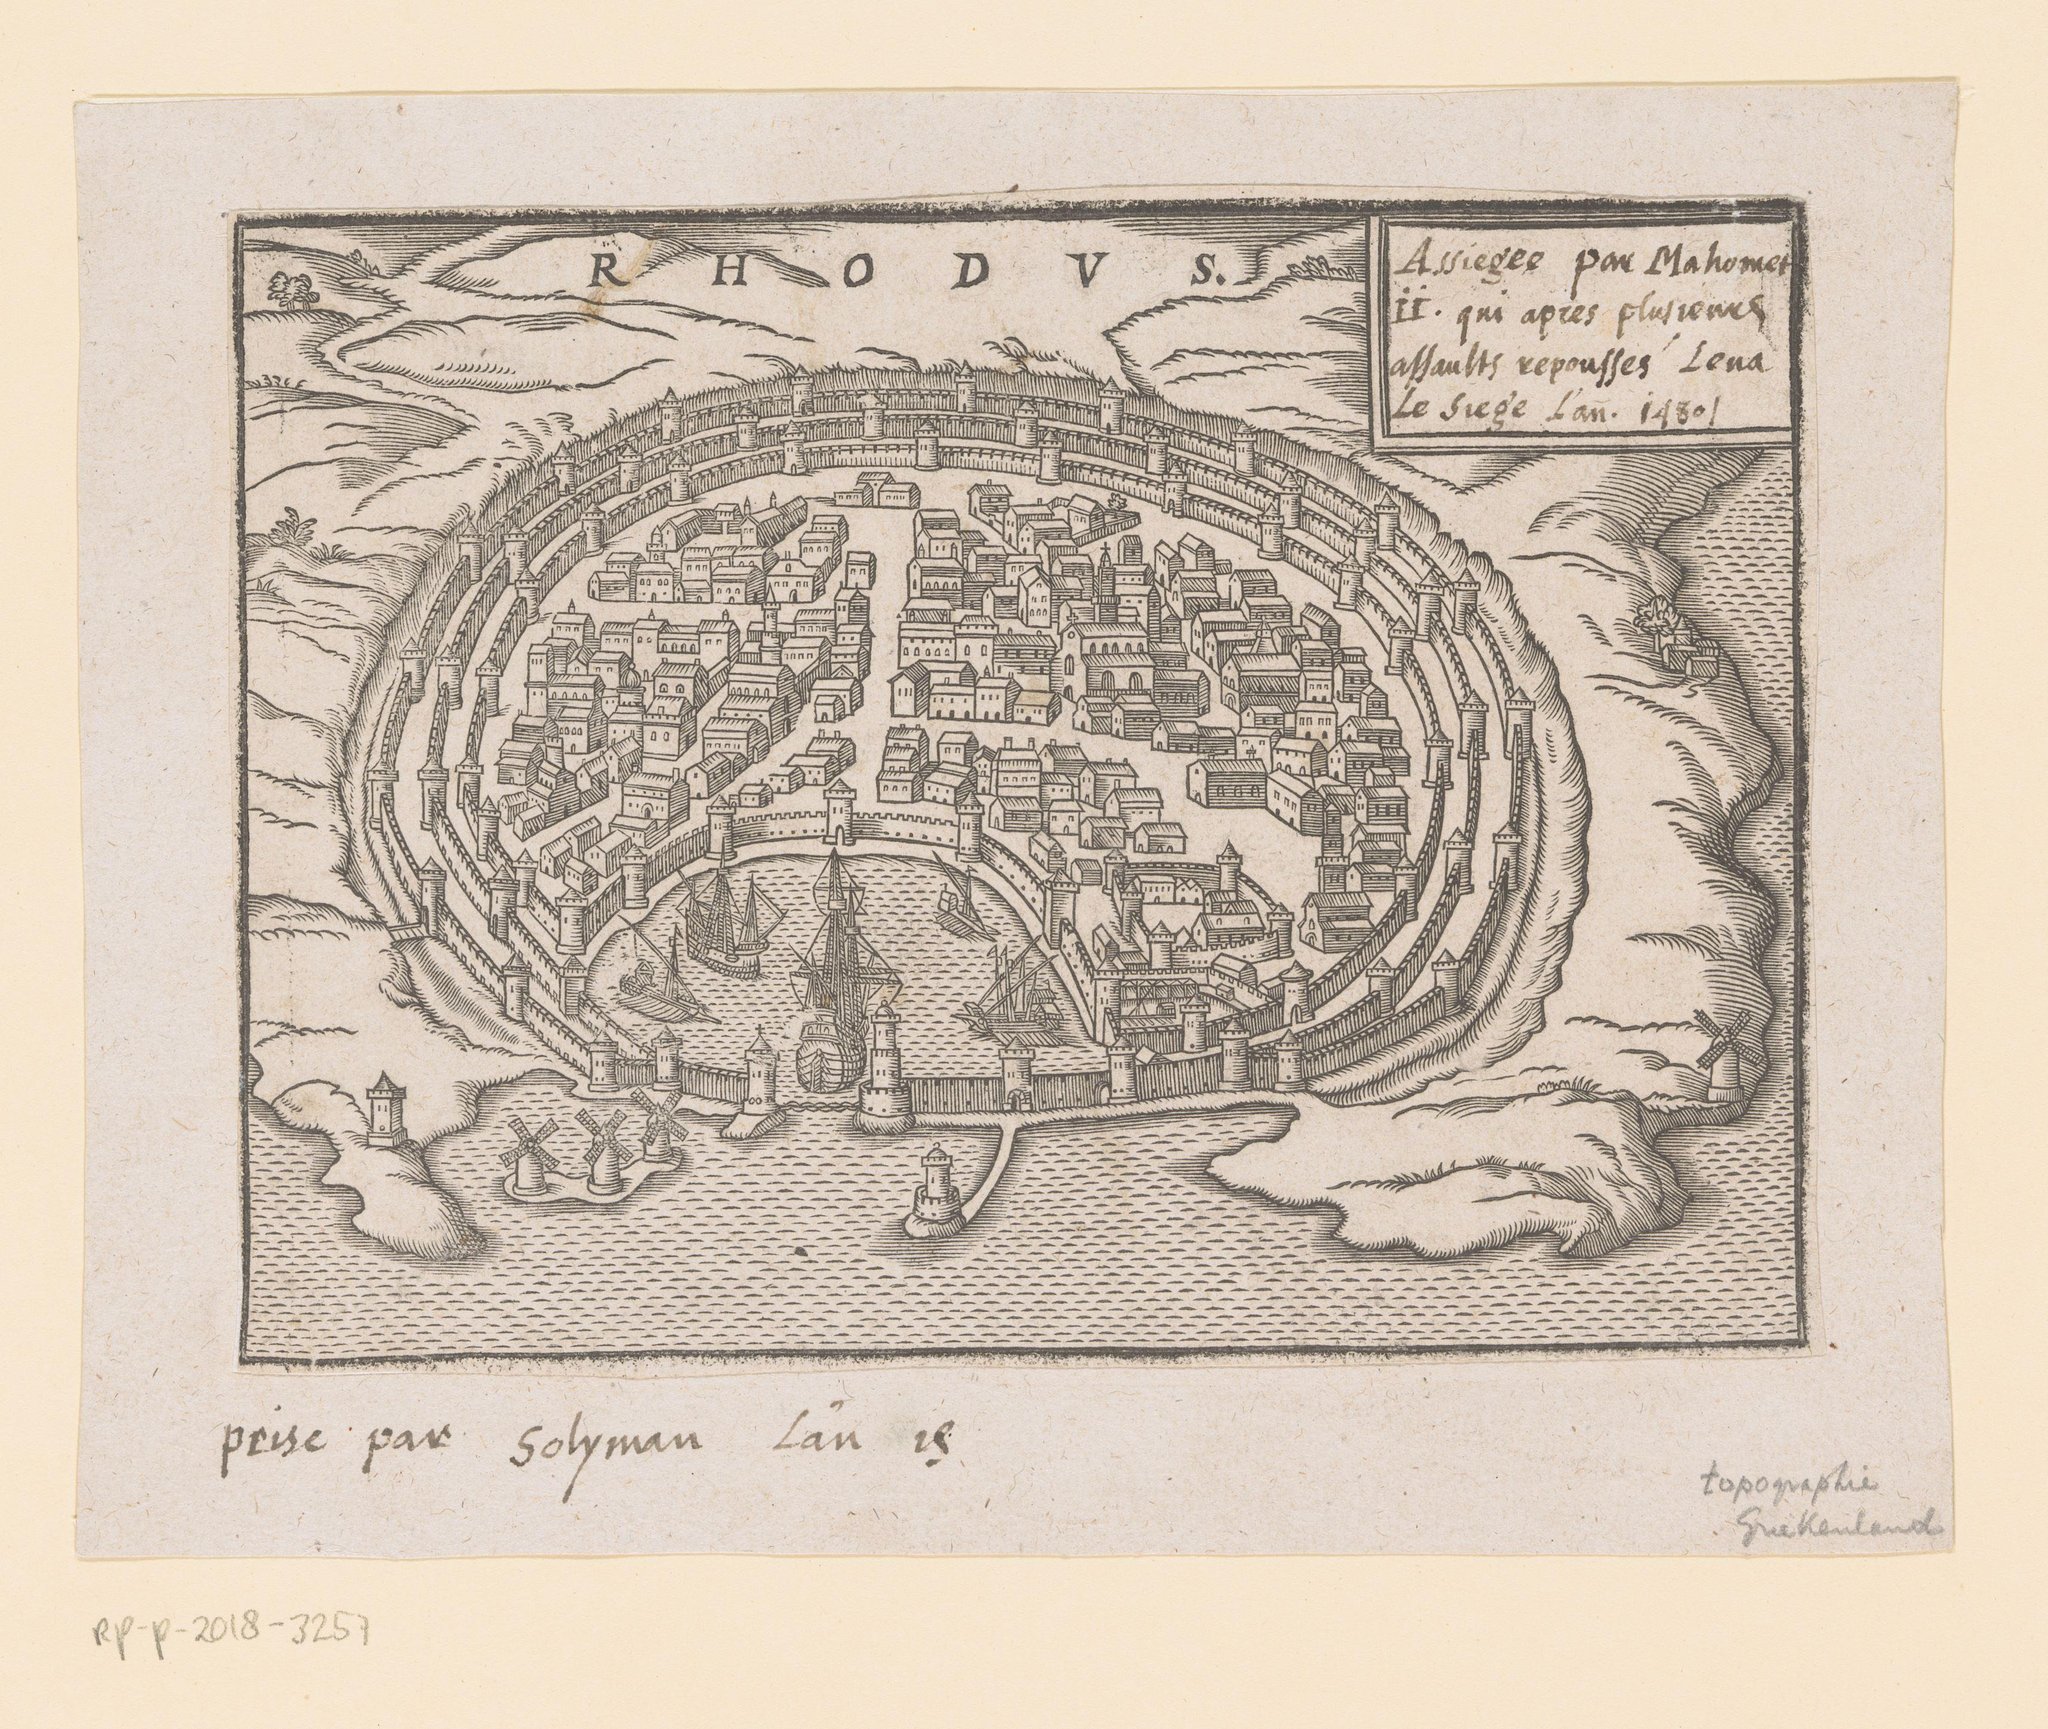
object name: print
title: Gezicht op Rodos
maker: Anonymous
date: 1550-1600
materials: paper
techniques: woodcut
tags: island, marine charts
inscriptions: inscription: ‘Assiegee par Mahomet (...)’, collector's mark: Lugt 2228, inscription: ‘Prise par Solyman (...)’